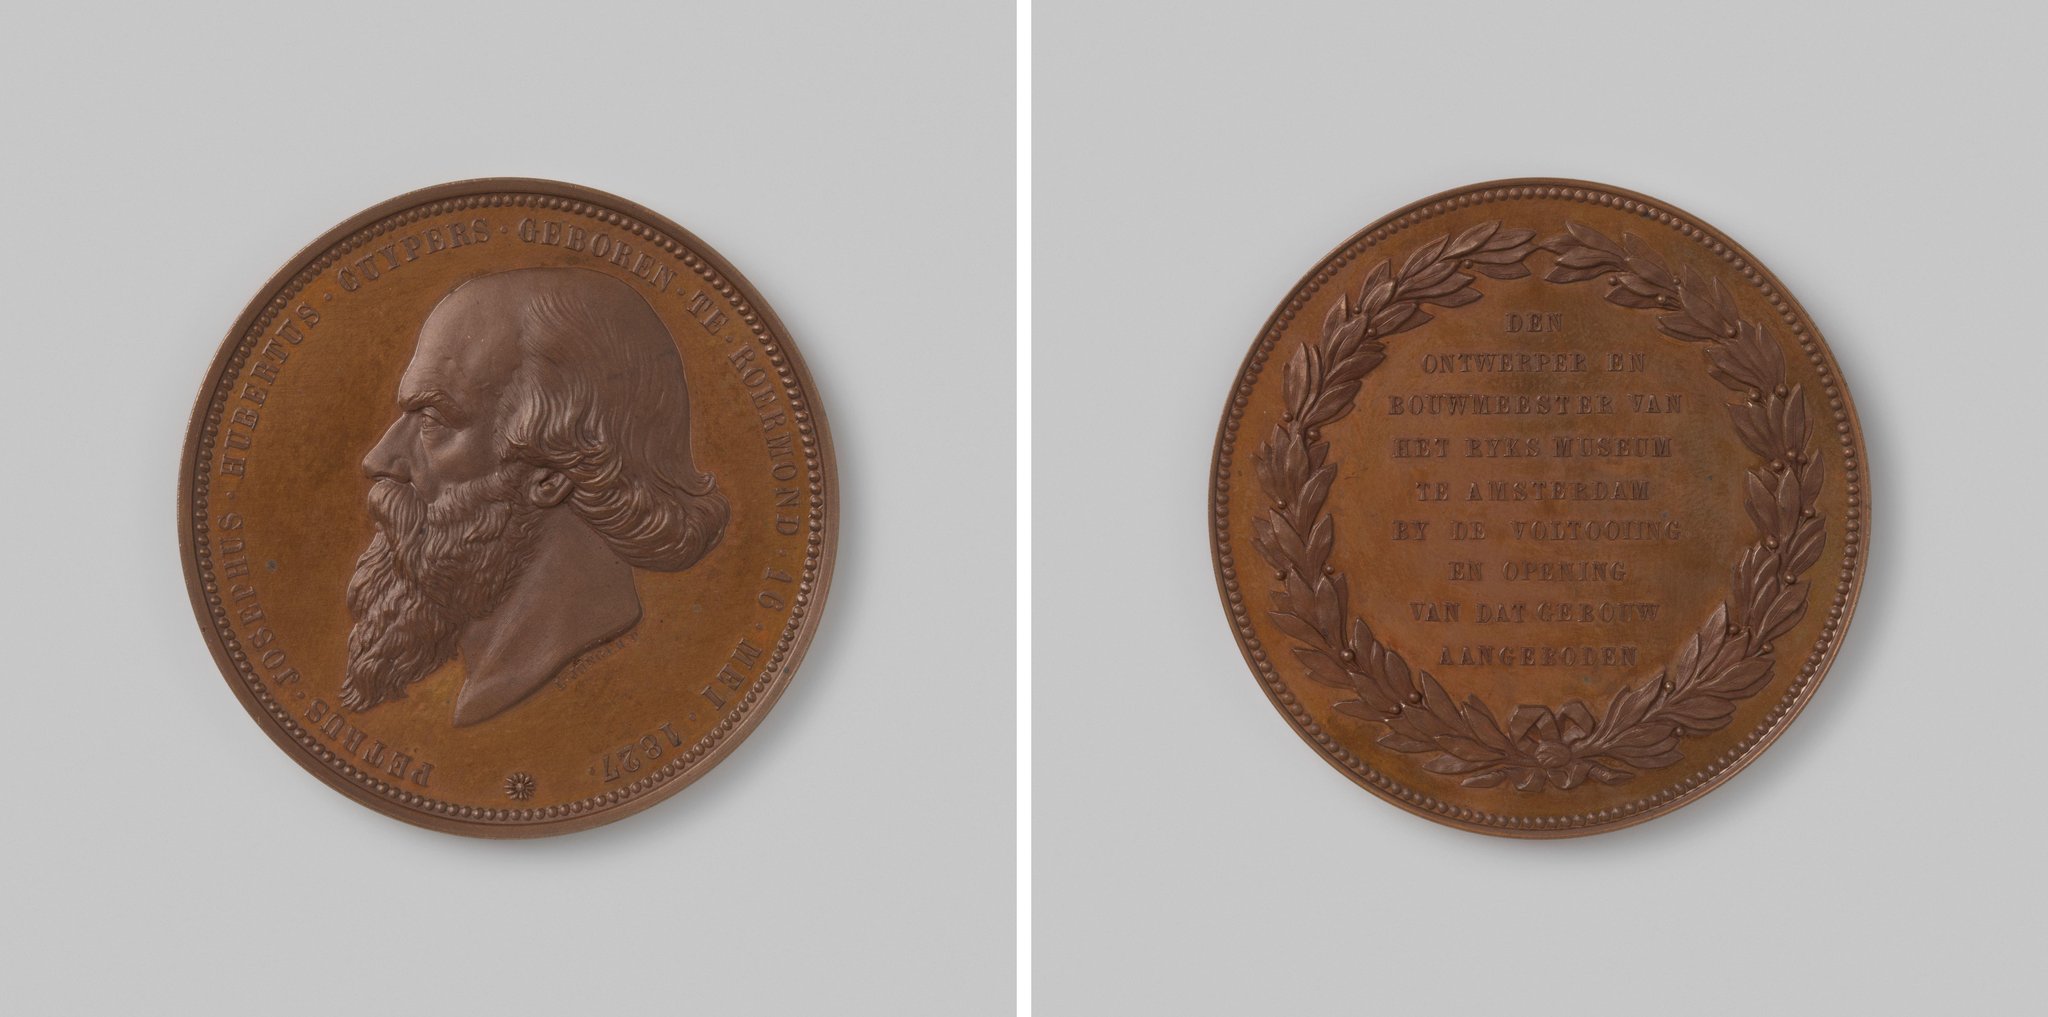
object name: history medal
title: Ter ere van bouwmeester P.J.H. Cuyper bij de opening van het Rijksmuseum 1885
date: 1885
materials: bronze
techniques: striking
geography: utrecht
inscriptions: factory mark: ‘mercuriusstaf’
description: Bronzen penning, op de voorzijde het portret van Cuyper naar links met omschrift, op de keerzijde negen regels tekst tussen samengestrikte lauwertakken.